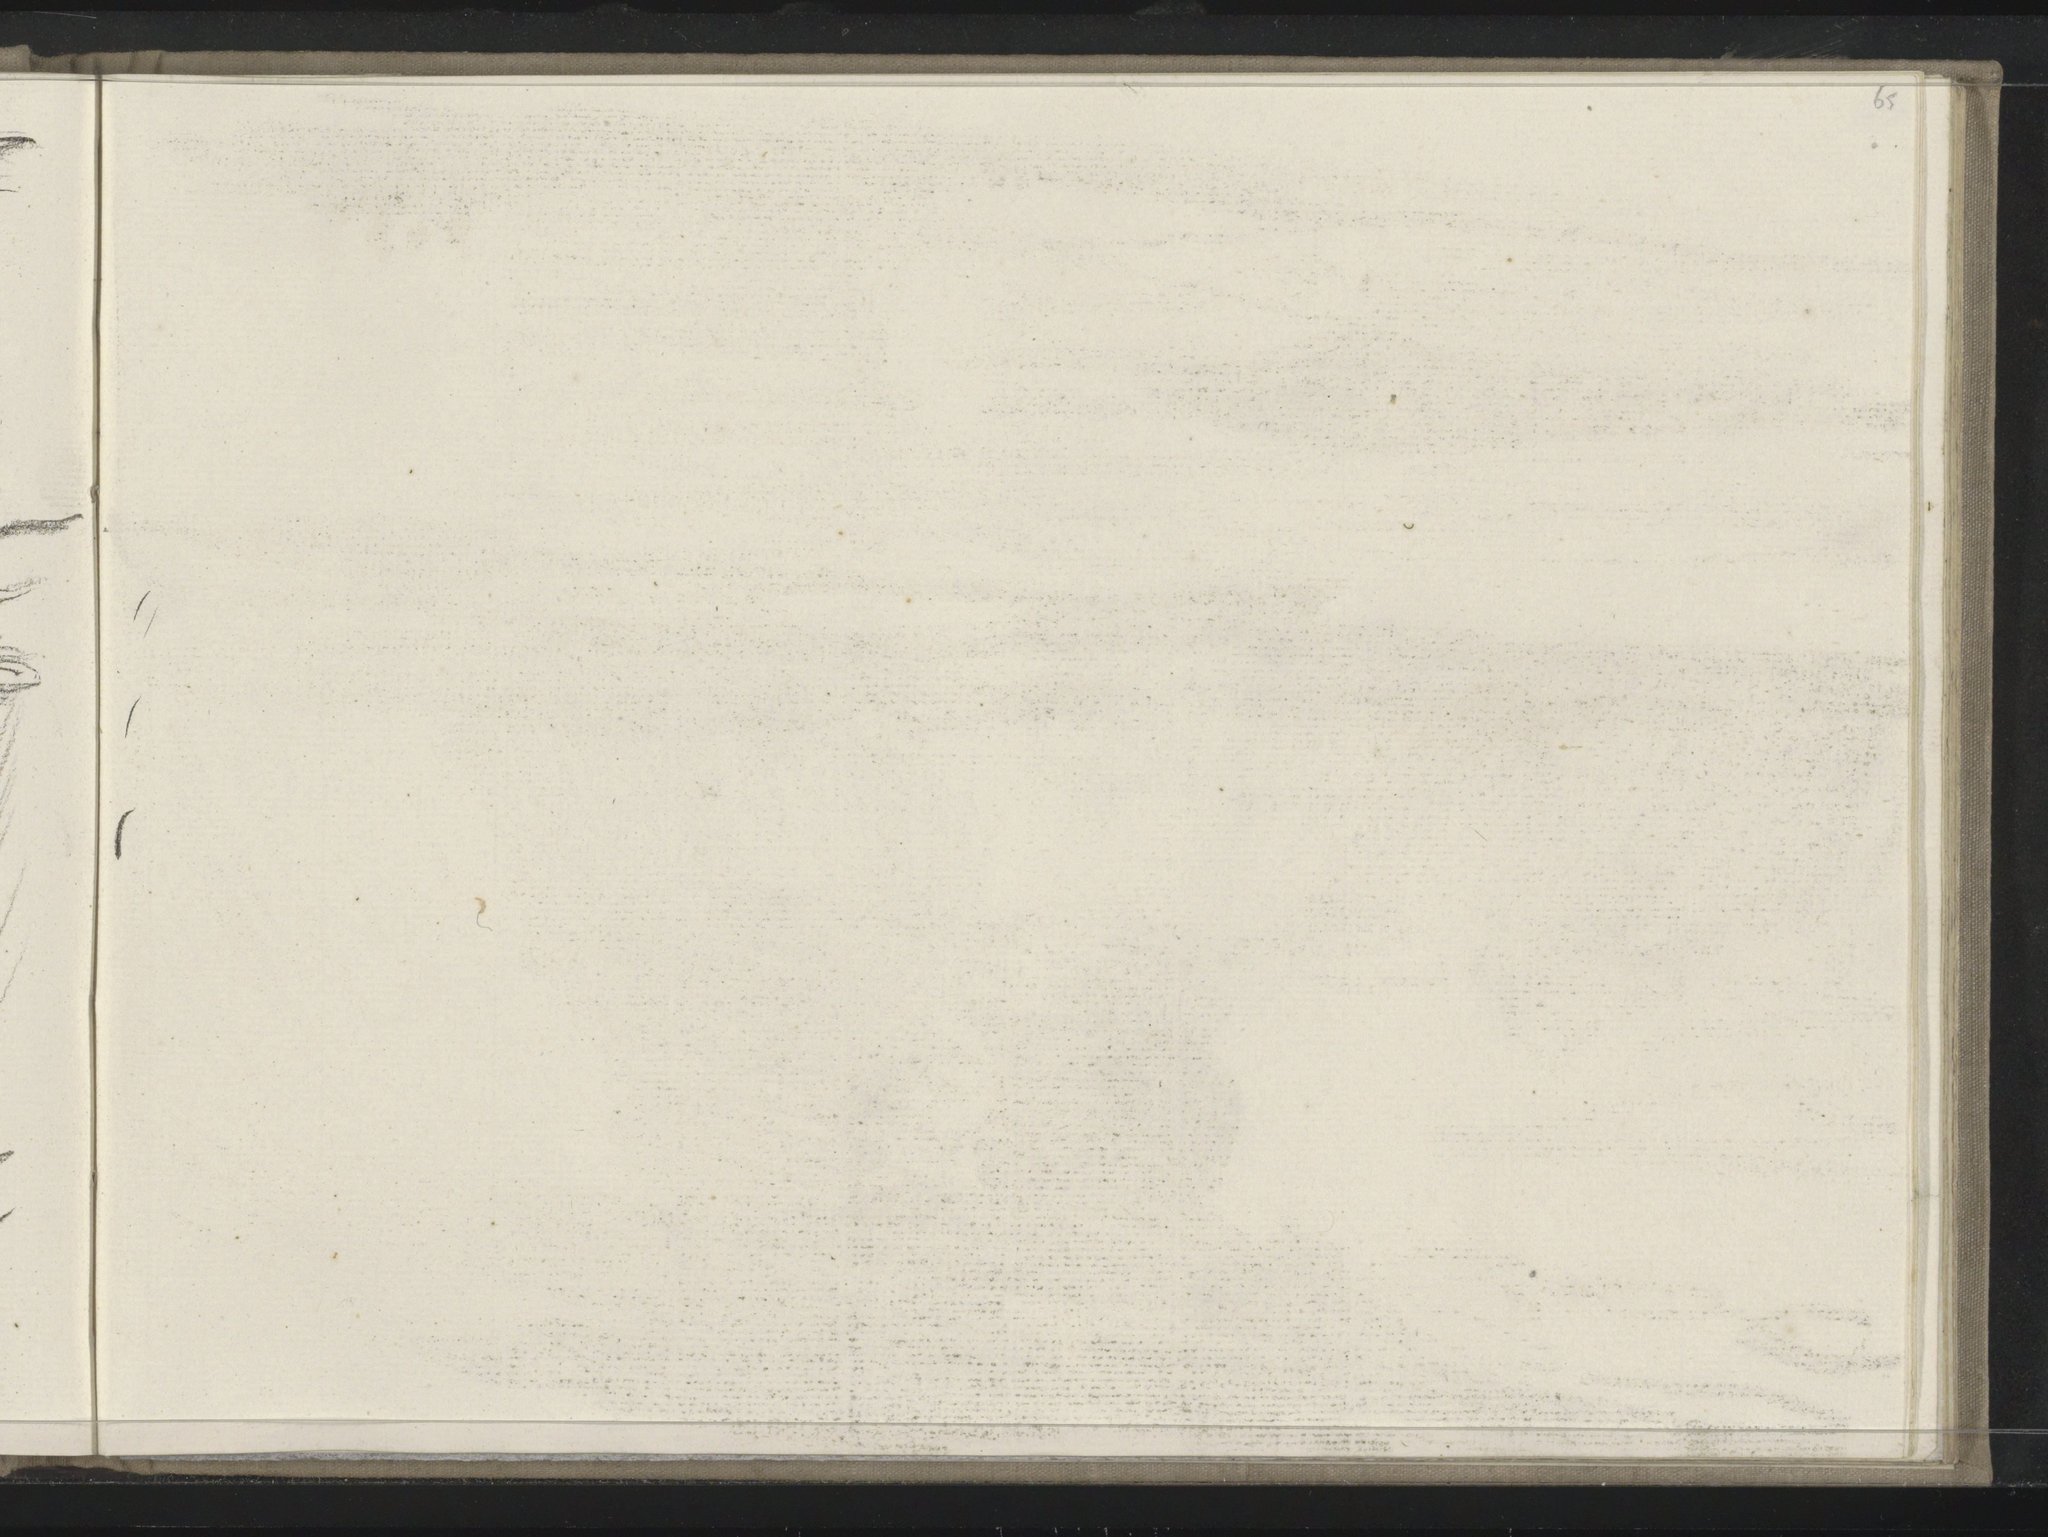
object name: sketchbook leaf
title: Abklatsch van de krijttekening op pagina 64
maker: willem witsen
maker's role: draughtsman, painter, print maker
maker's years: 1860-1923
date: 1888-1907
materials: paper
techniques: printmaking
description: Pagina 65 uit een schetsboek met 72 bladen.